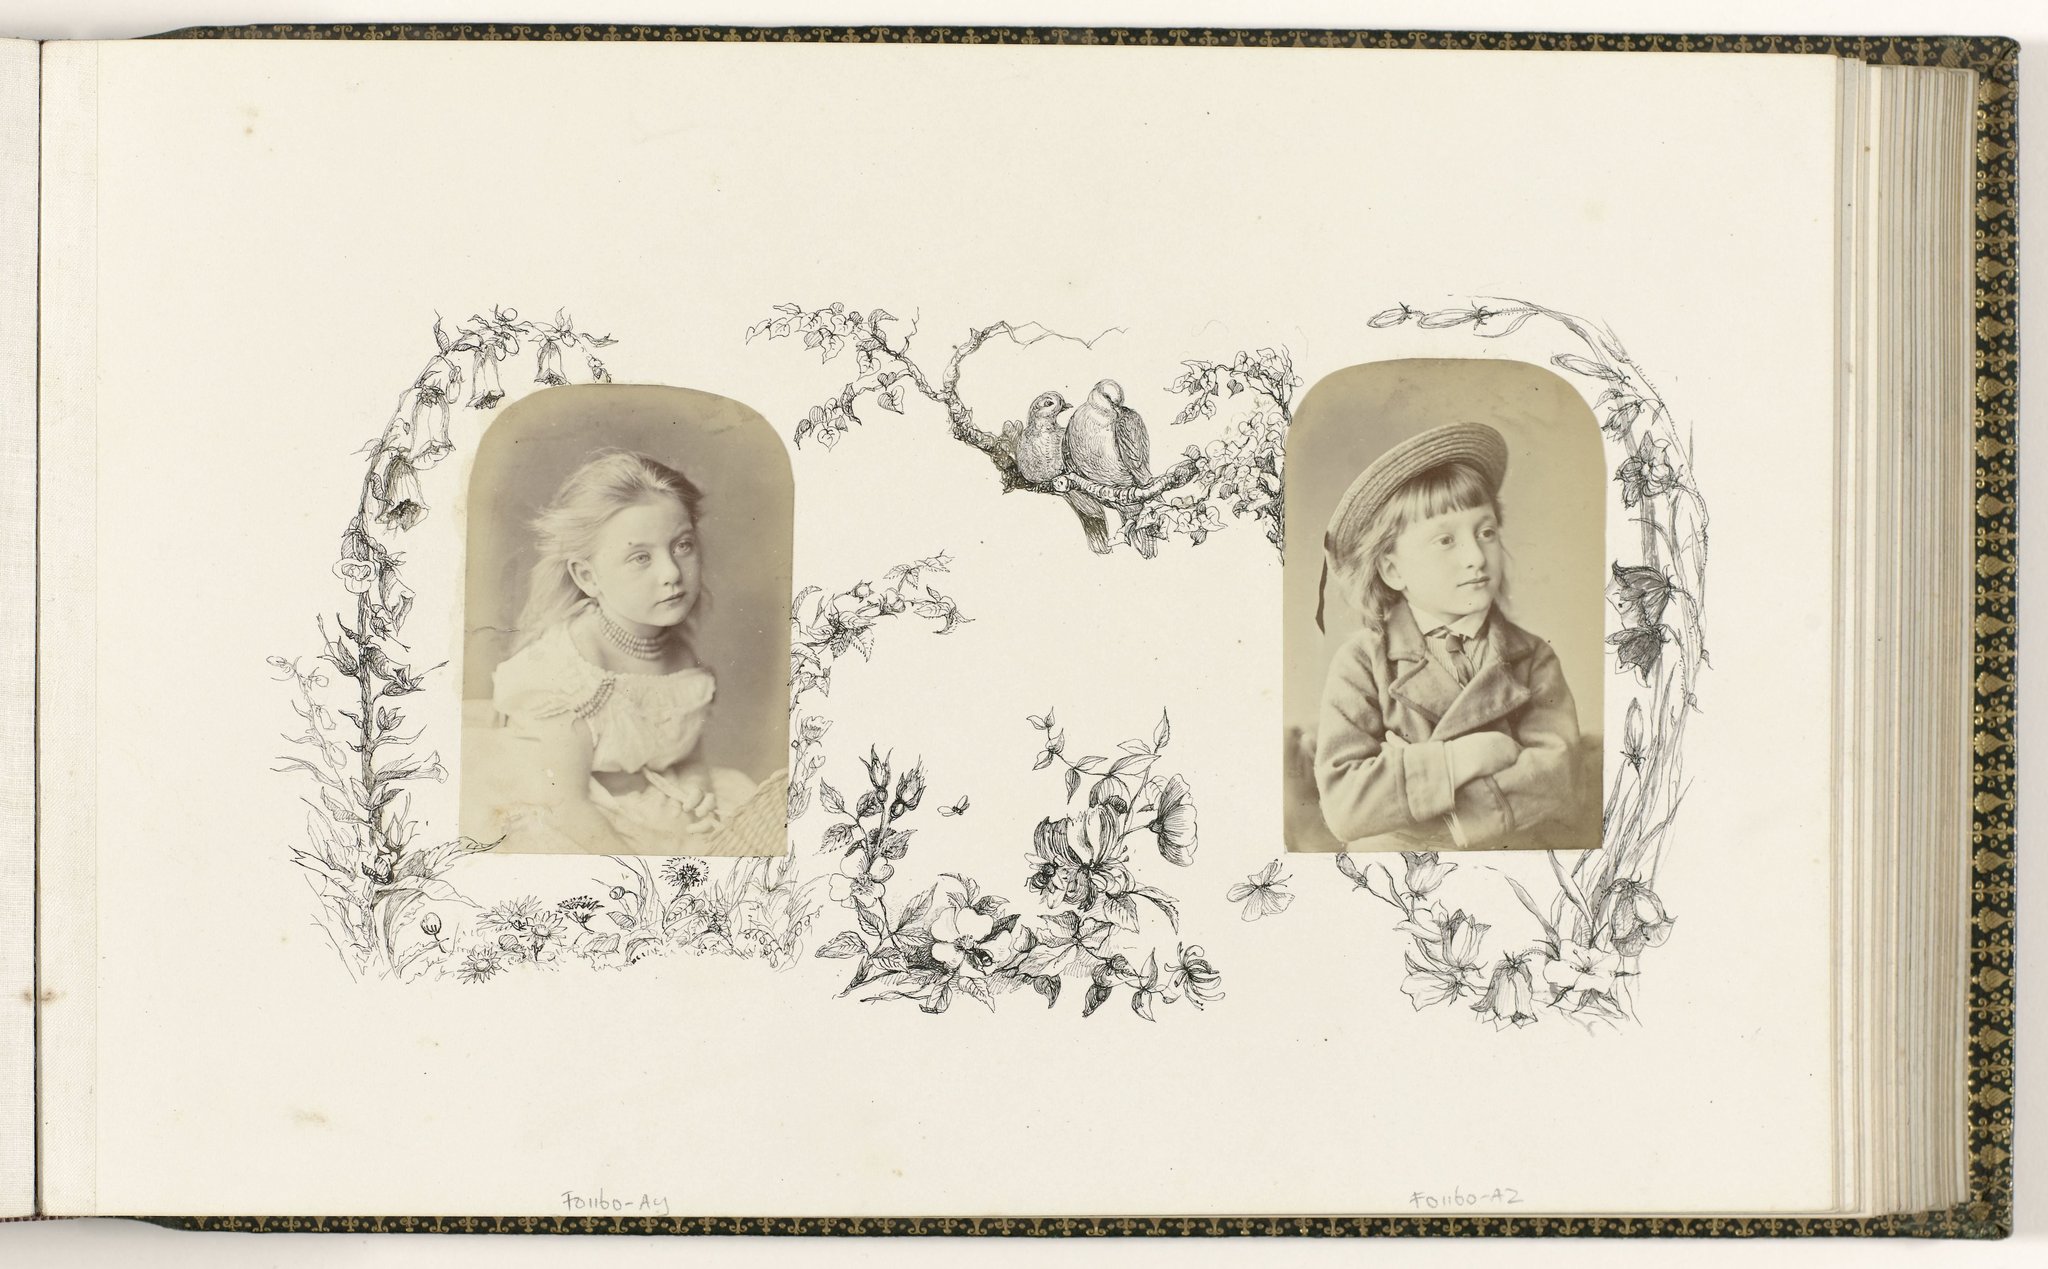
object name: album leaf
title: Portret van een onbekend meisje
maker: Anonymous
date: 1870-1880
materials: paper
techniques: albumen print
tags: historical persons, girl (child between toddler and youth)